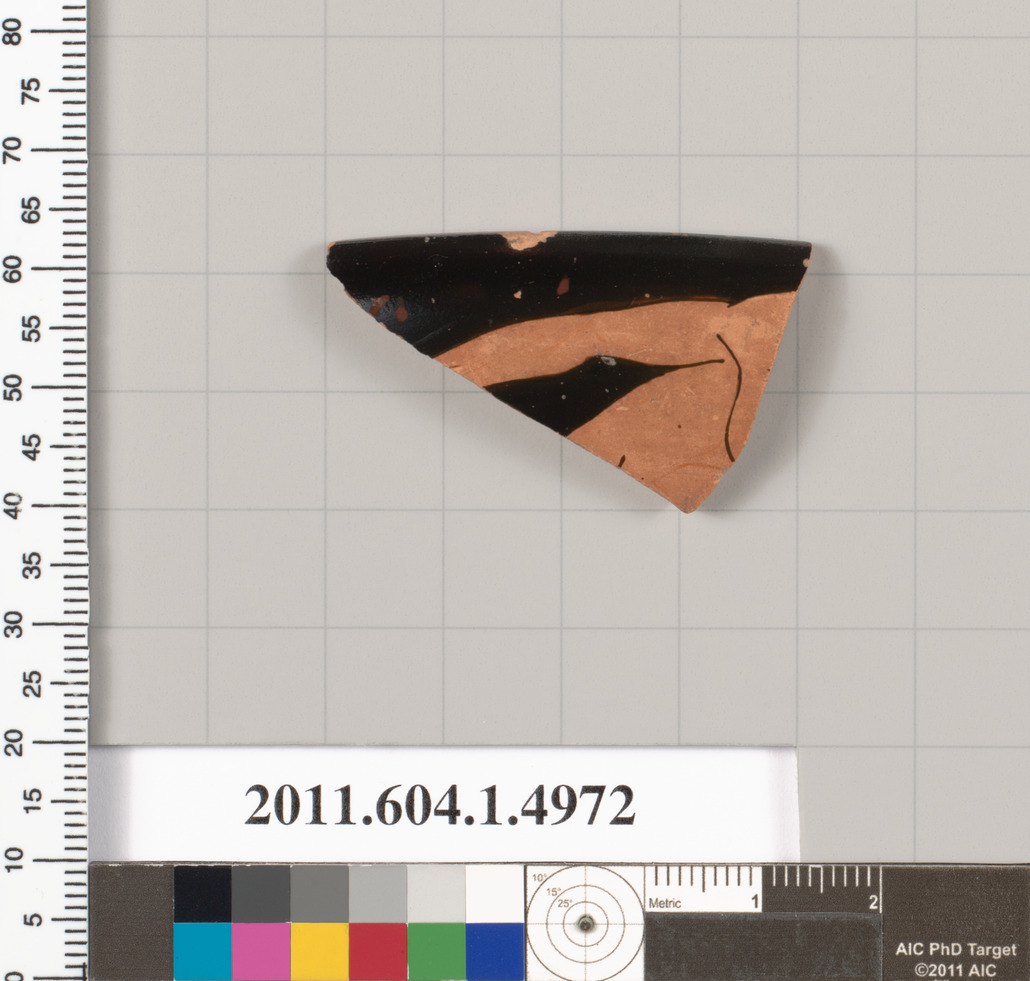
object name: kylix fragment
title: Terracotta rim fragment of a kylix (drinking cup)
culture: greek, attic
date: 490-480 BCE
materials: terracotta